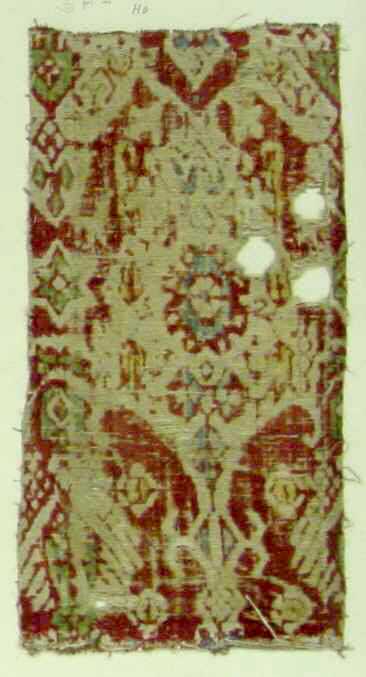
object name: textile fragment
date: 1601-1633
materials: silk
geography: turkey